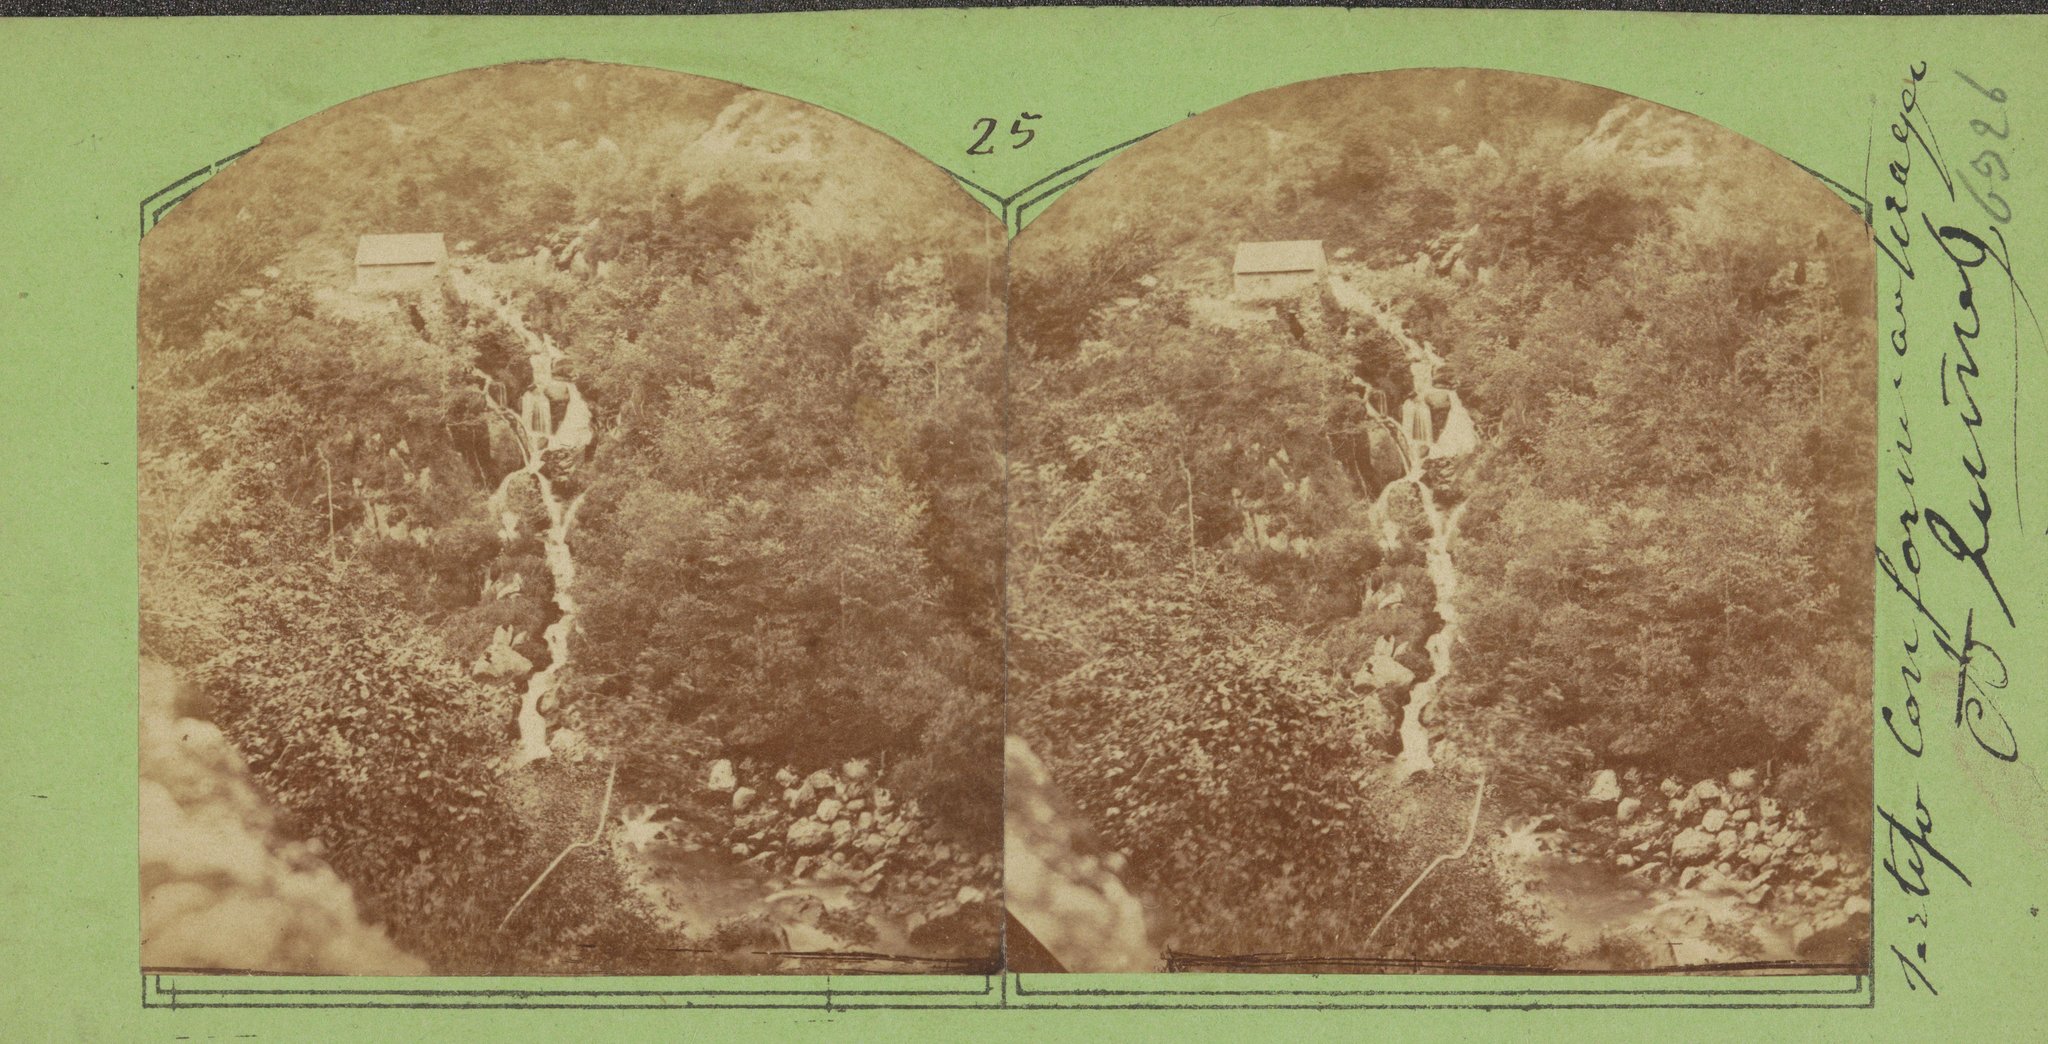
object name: stereograph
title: Berglandschap met bomen met daarin een gebouw, water mondt via de berg uit in een rivier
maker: achille quinet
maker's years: 1831-1900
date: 1860-1880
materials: cardboard, paper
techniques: albumen print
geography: alps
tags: mountains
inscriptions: signature: ‘Sertifier conforme au tirages // A Quinet’